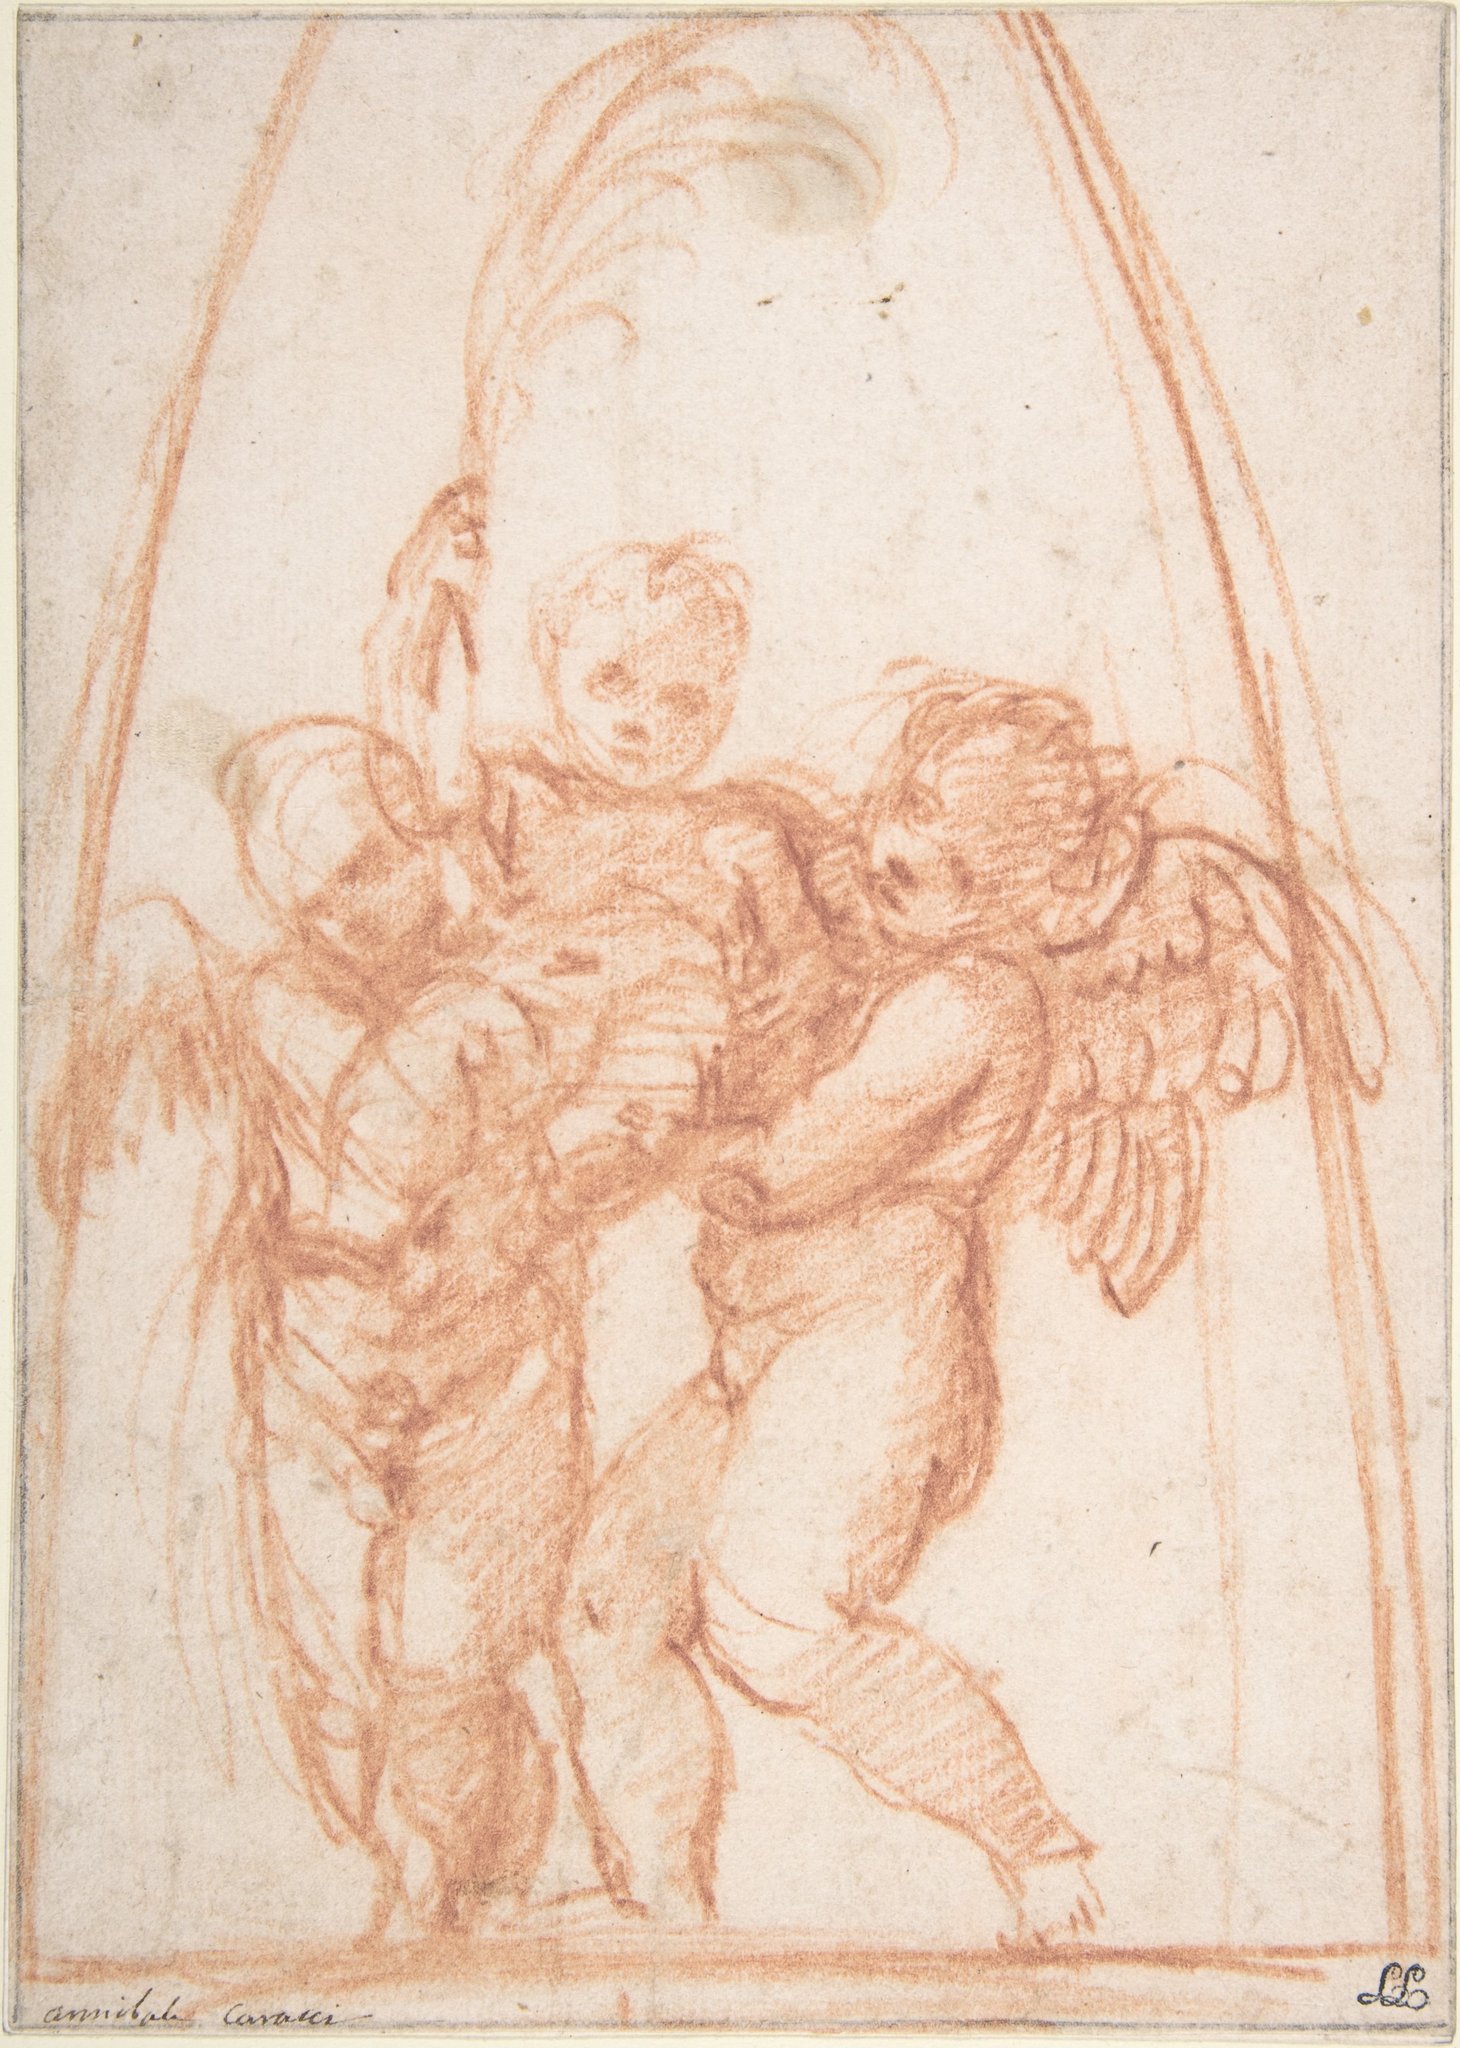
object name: drawing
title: Anteros Victorious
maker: annibale carracci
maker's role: artist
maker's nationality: italian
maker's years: 1560-1609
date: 1560-1609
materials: chalk